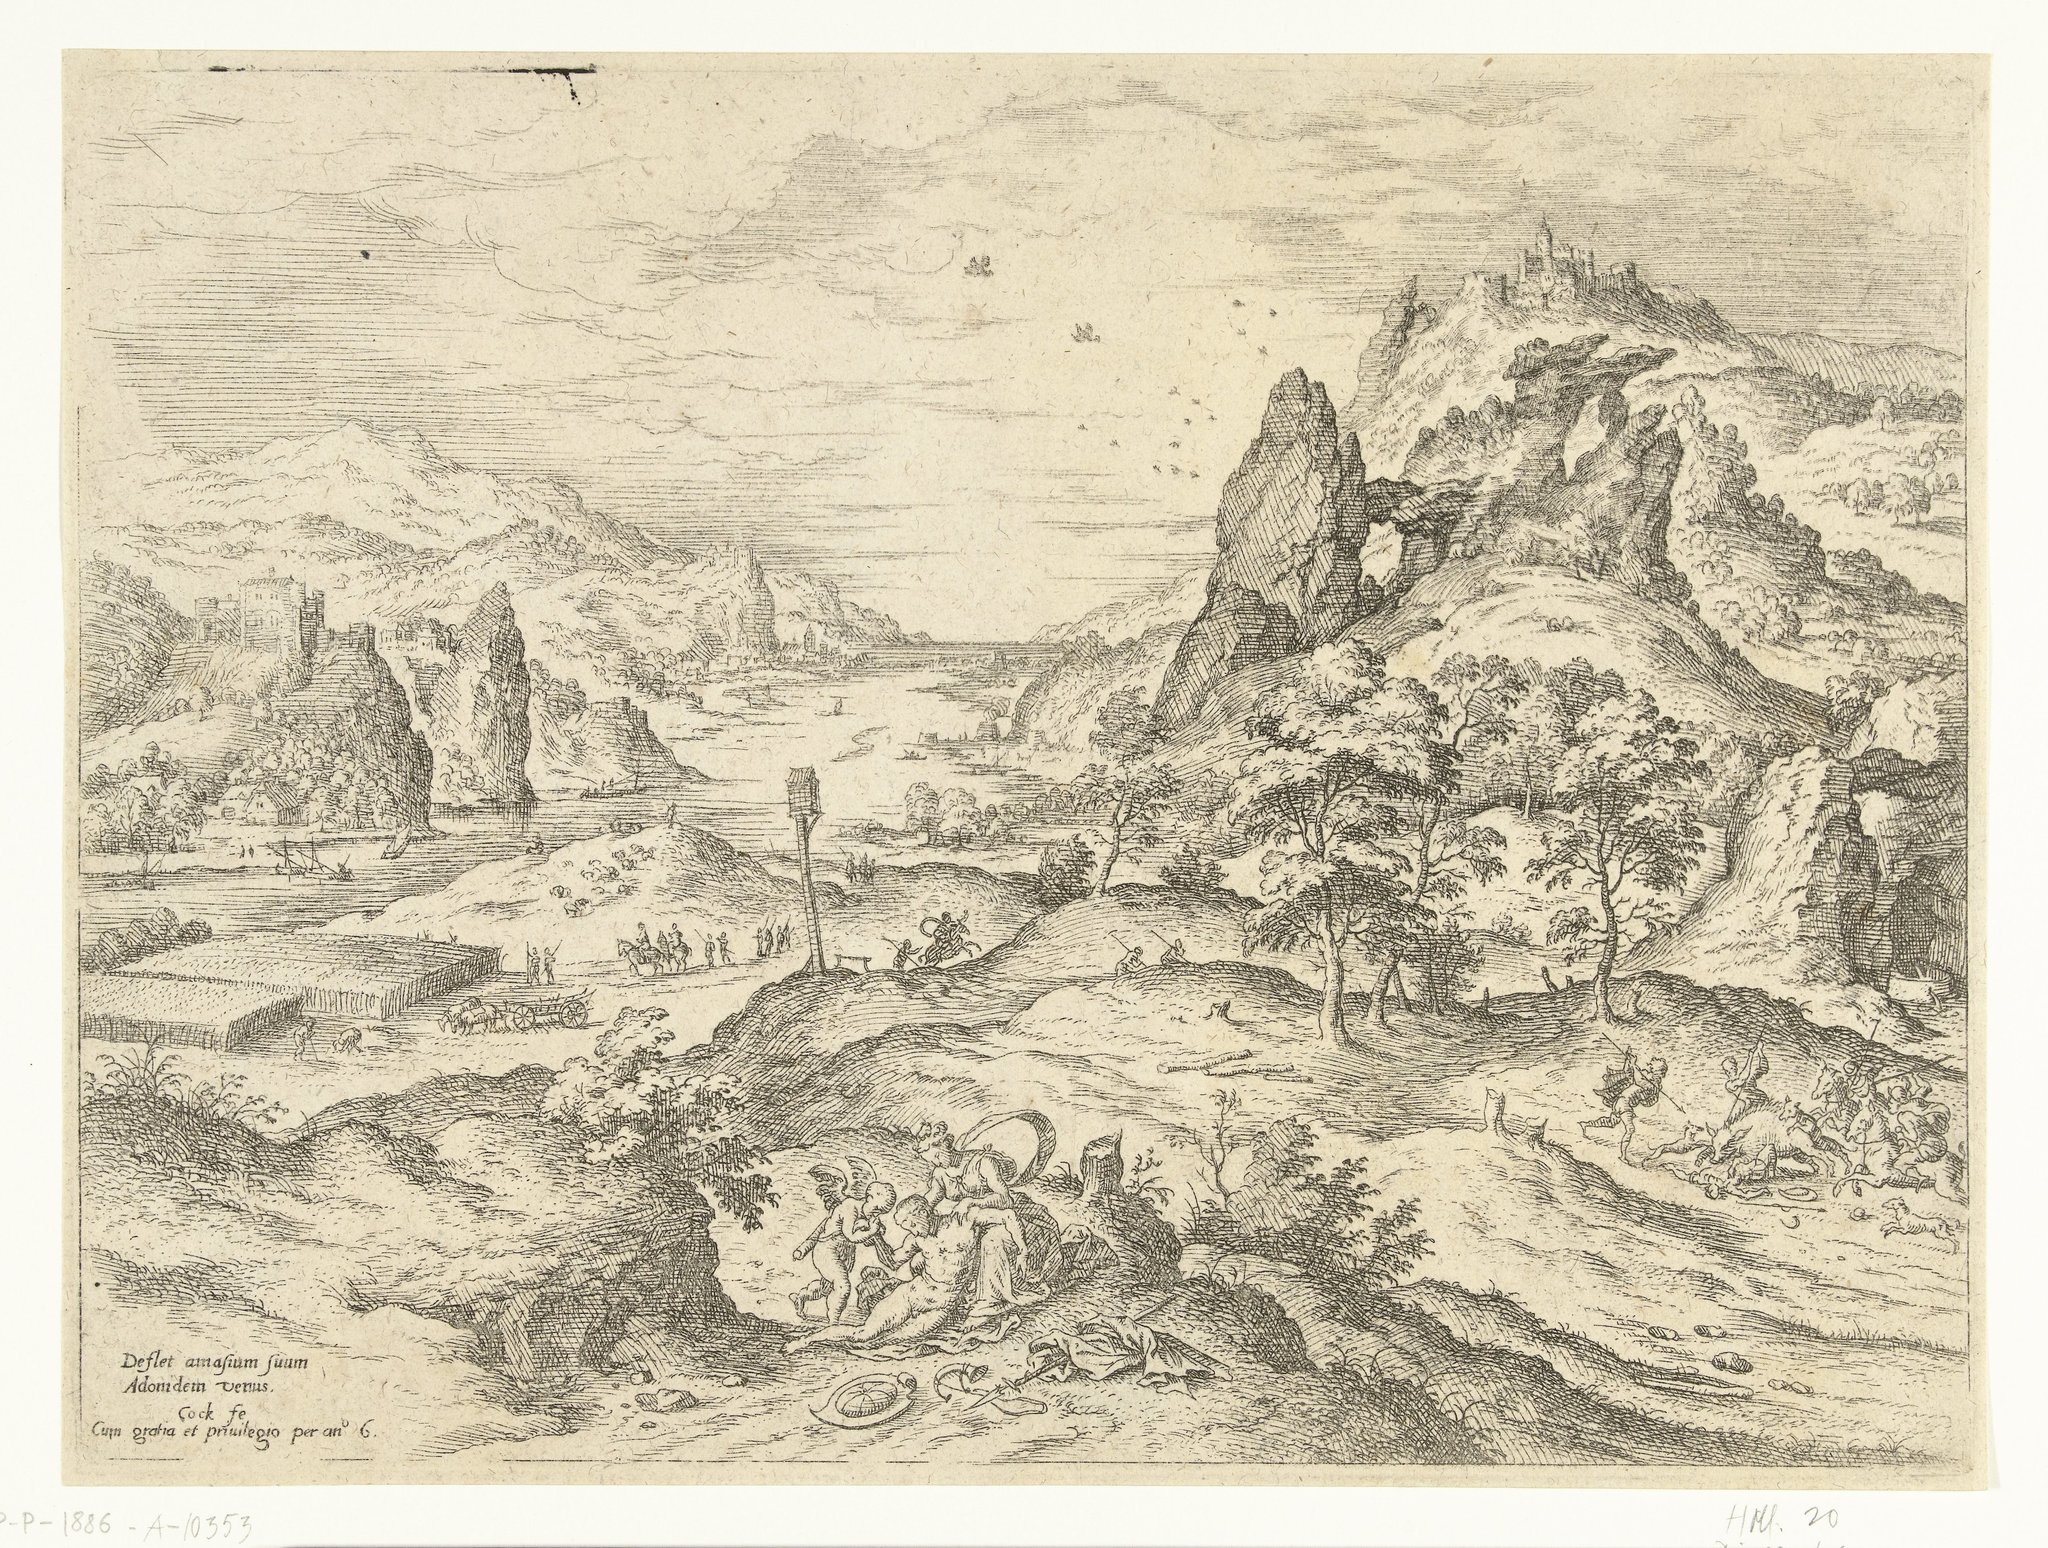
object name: print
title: Venus treurt over de dood van Adonis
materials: paper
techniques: etching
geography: antwerp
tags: venus mourning adonis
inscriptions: collector's mark: Lugt 2228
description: Landschap met jachtscènes. Rechts is te zien hoe Adonis gedood wordt door een everzwijn. In het midden Venus en Amor die treuren om de dode Adonis. Prent uit een serie van 13 landschappen met bijbelse en mythologische scènes.